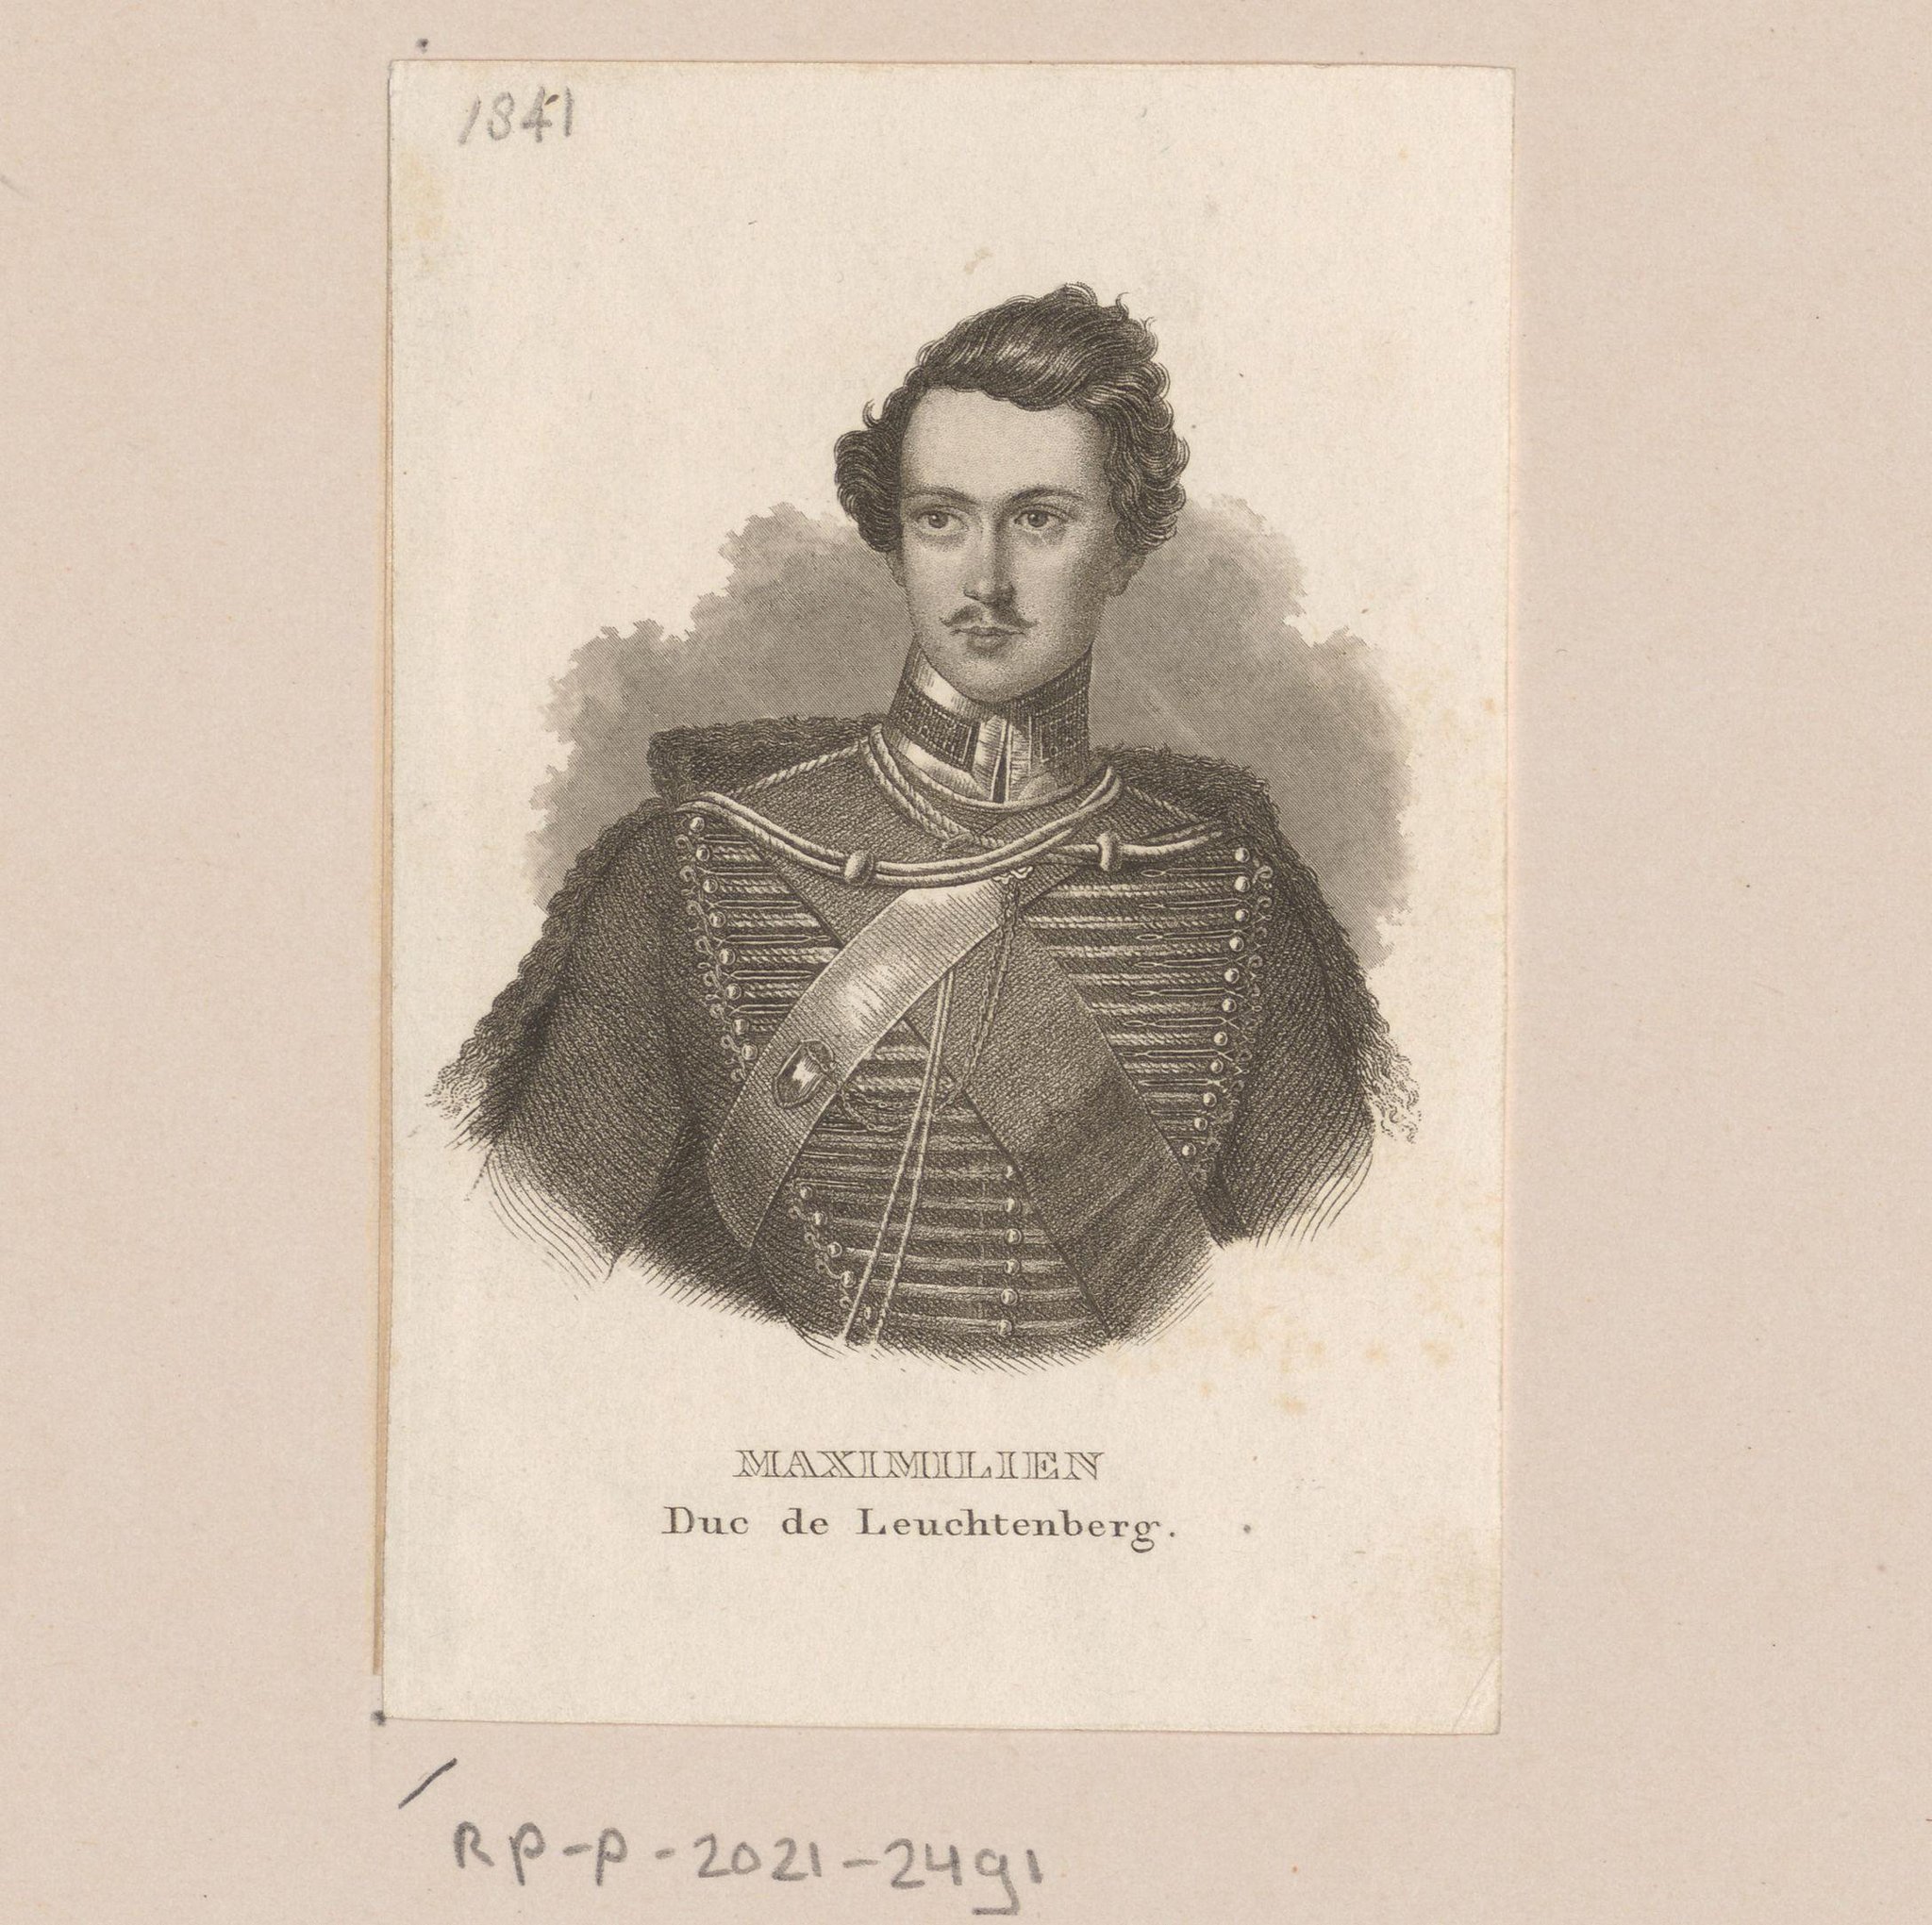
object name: print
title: Portret van Maximiliaan van Leuchtenberg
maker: Anonymous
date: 1841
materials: paper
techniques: etching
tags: historical persons, (military) uniforms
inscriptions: inscription: ‘1841’